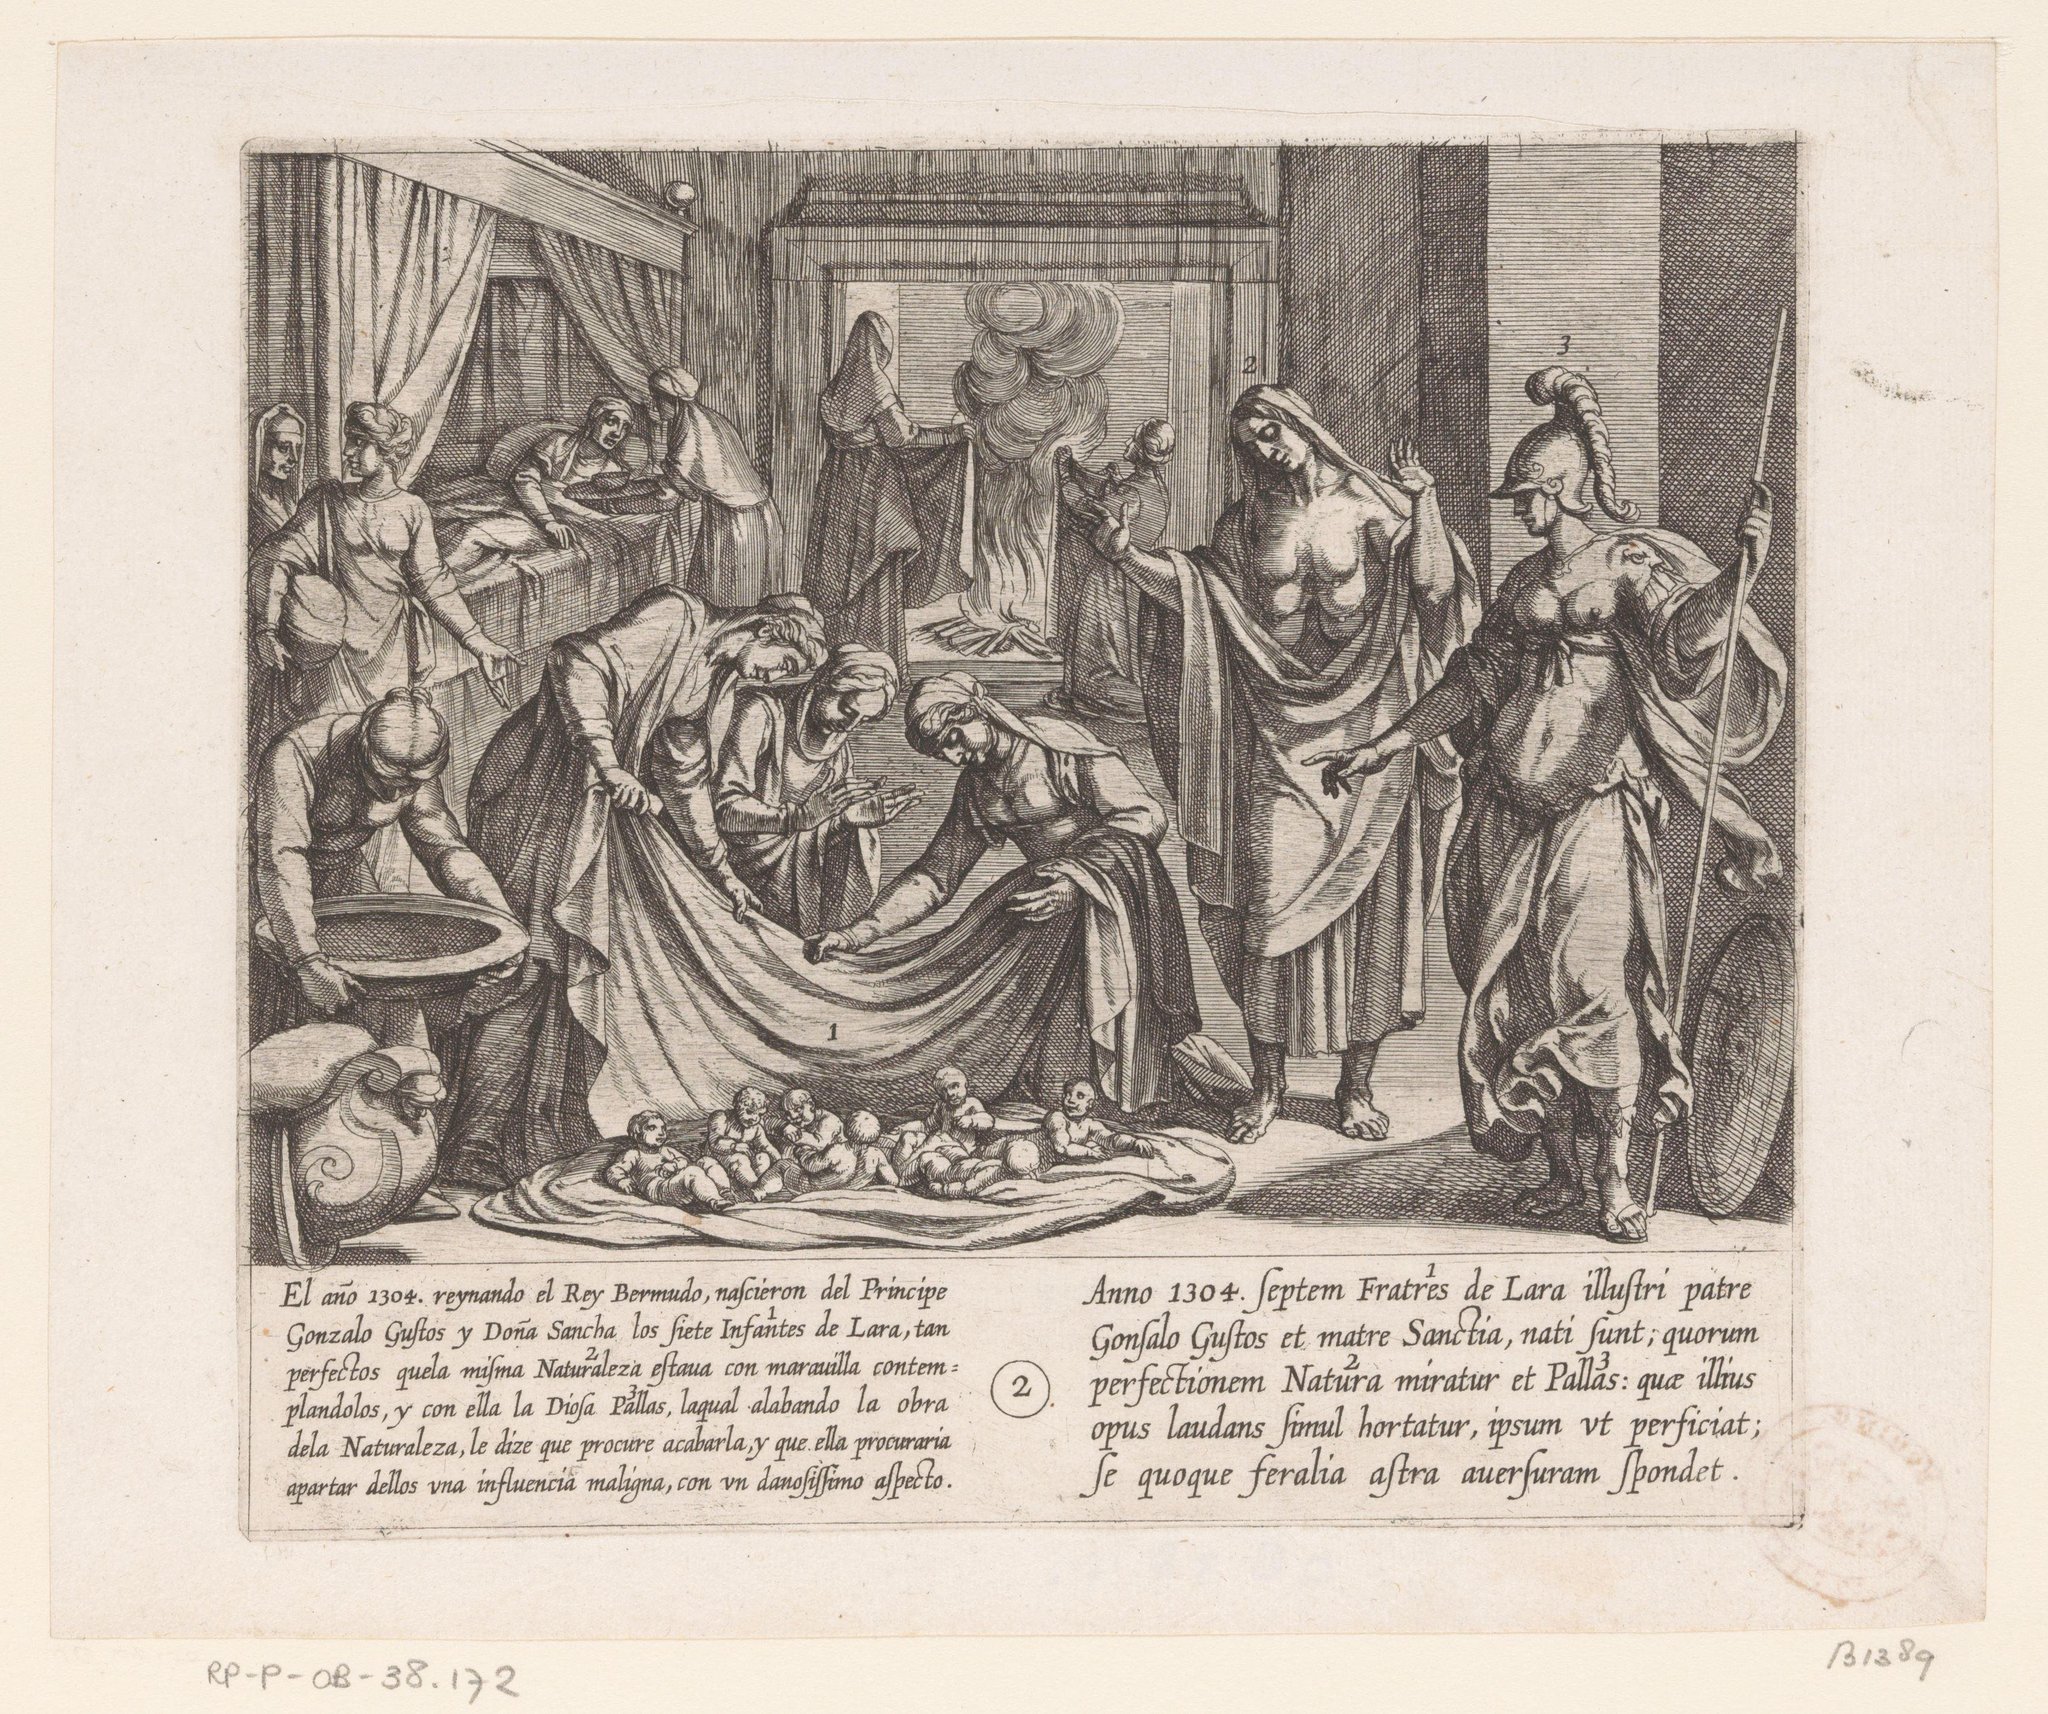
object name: print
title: Historia Septem Infantium de Lara/ Historia de los Siete Infantes de Lara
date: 1612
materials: paper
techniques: etching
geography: antwerp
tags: (story of) pallas, tales and fairy tales, infant, baby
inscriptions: collector's mark: Lugt 240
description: Deze prent maakt deel uit van een reeks van 40 prenten (+ titelprent) met voorstellingen uit het volksverhaal over de zeven infanten van Lara.